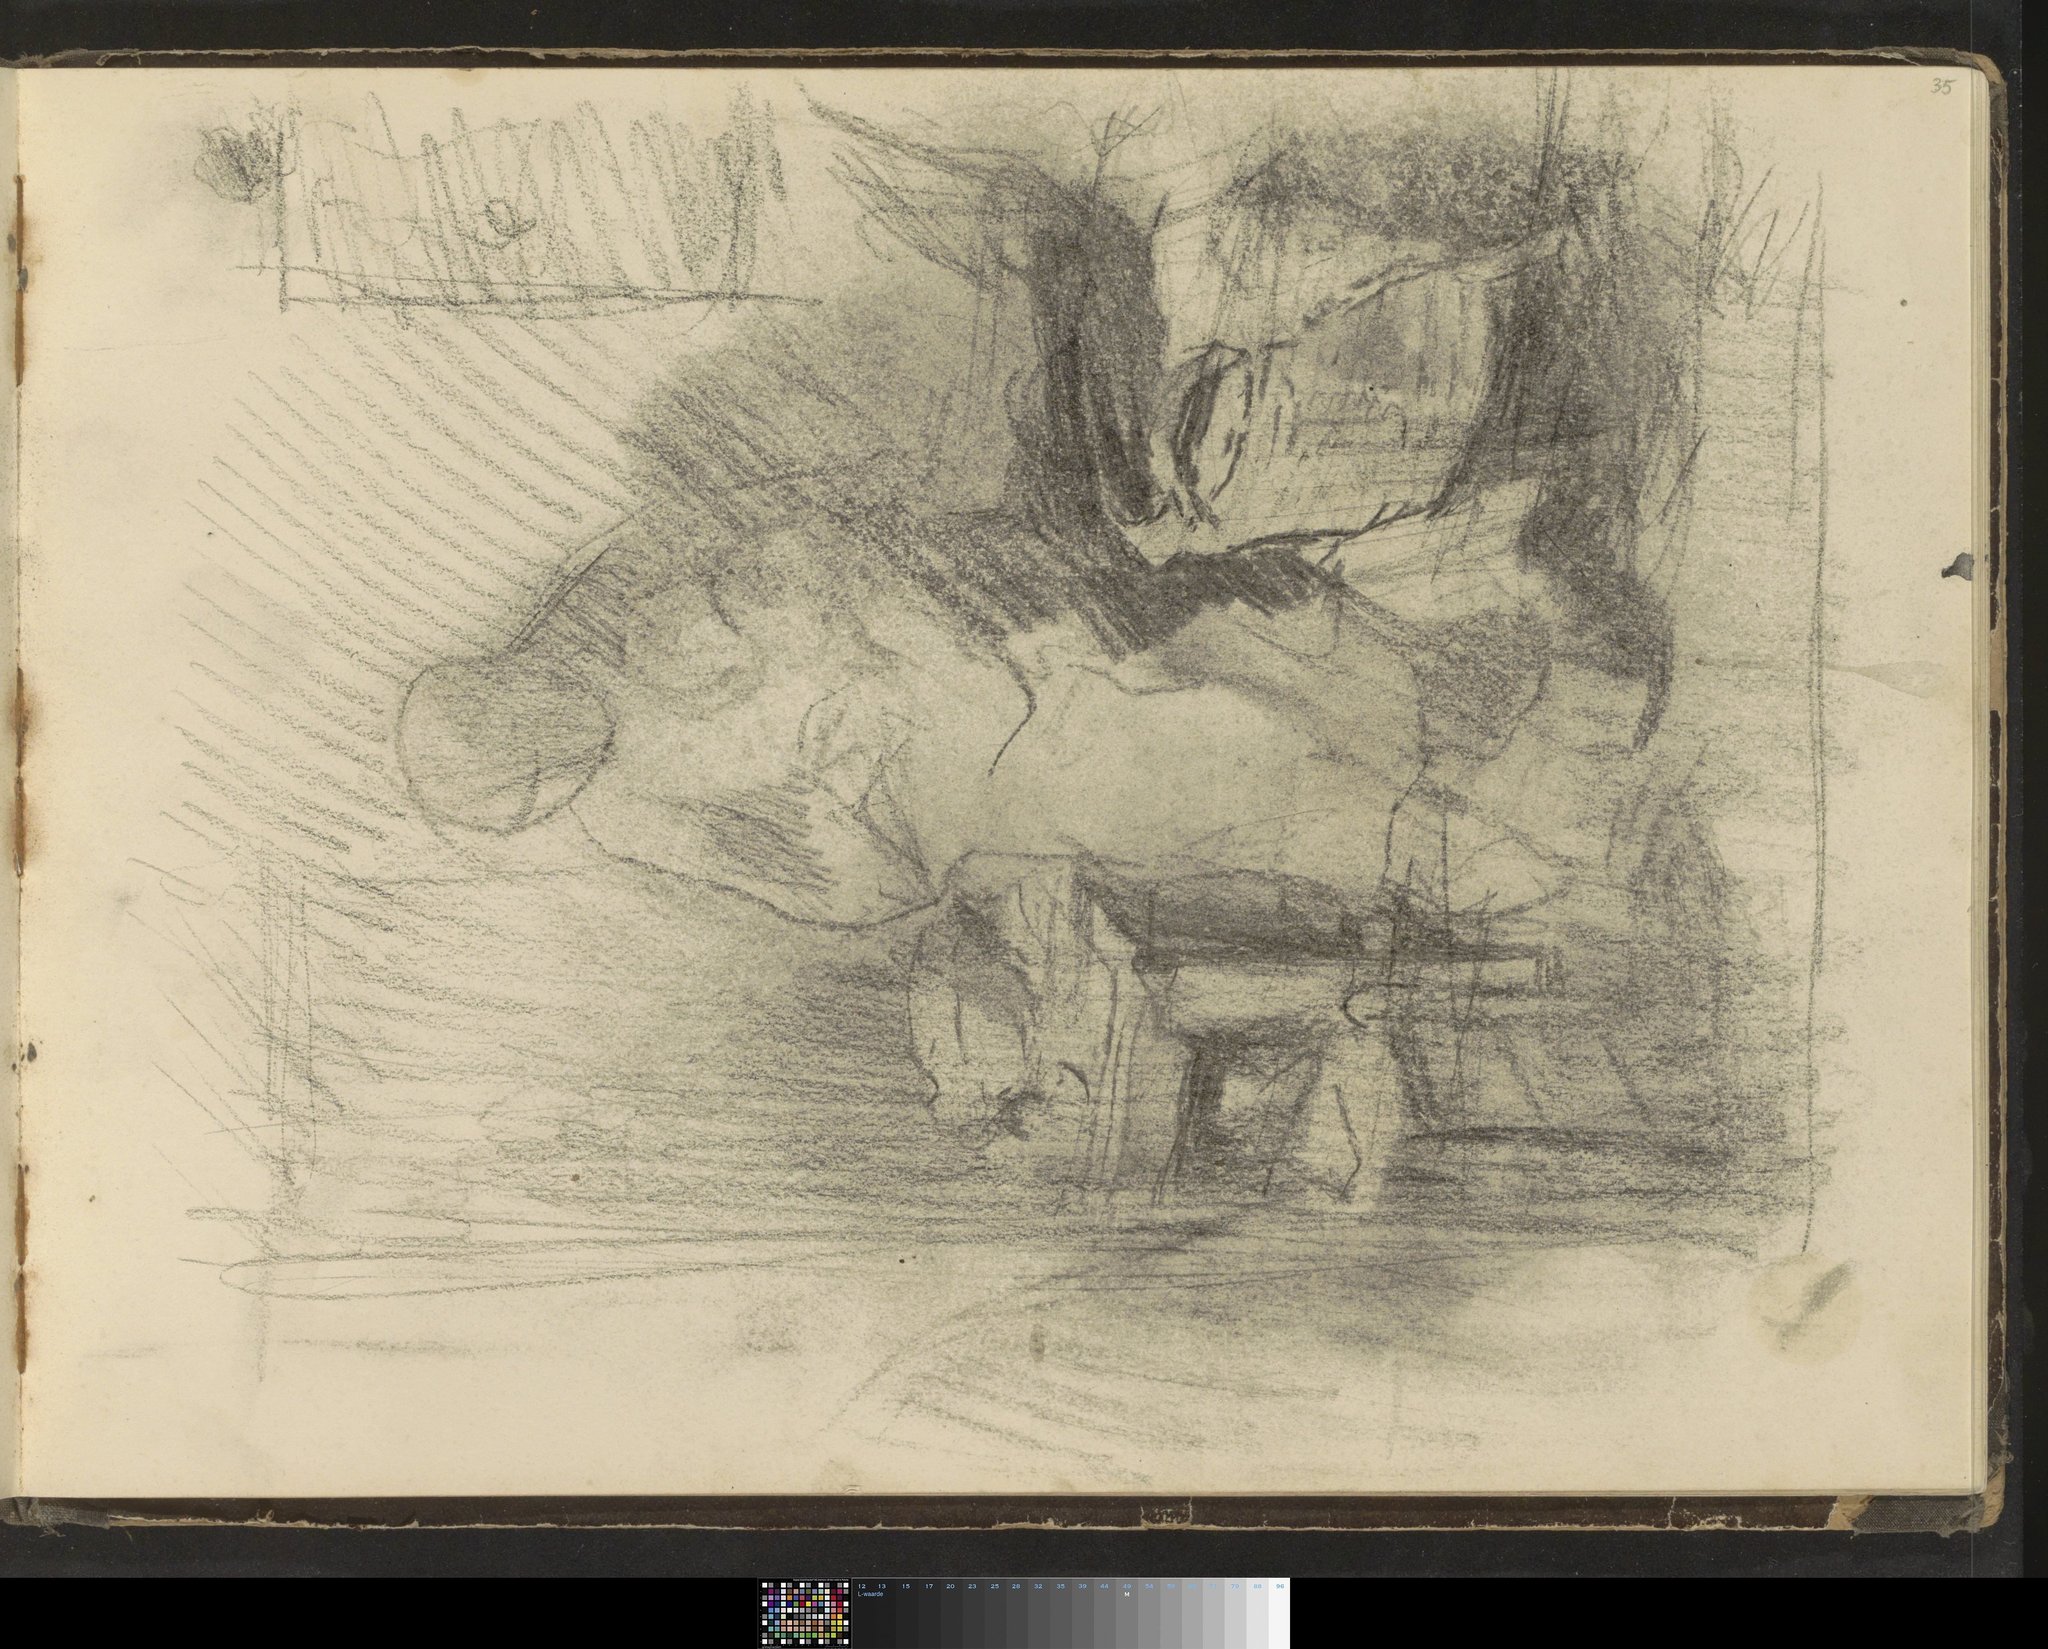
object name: sketchbook leaf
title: Vrouw met een baby op de arm bij een rieten wieg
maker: albert neuhuys (1844-1914)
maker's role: draughtsman, painter, print maker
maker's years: 1844-1914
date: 1854-1914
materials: charcoal, paper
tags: adult woman, interior of the house, cradle, crib, infant, baby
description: Blad 35 recto uit een schetsboek met 43 bladen.